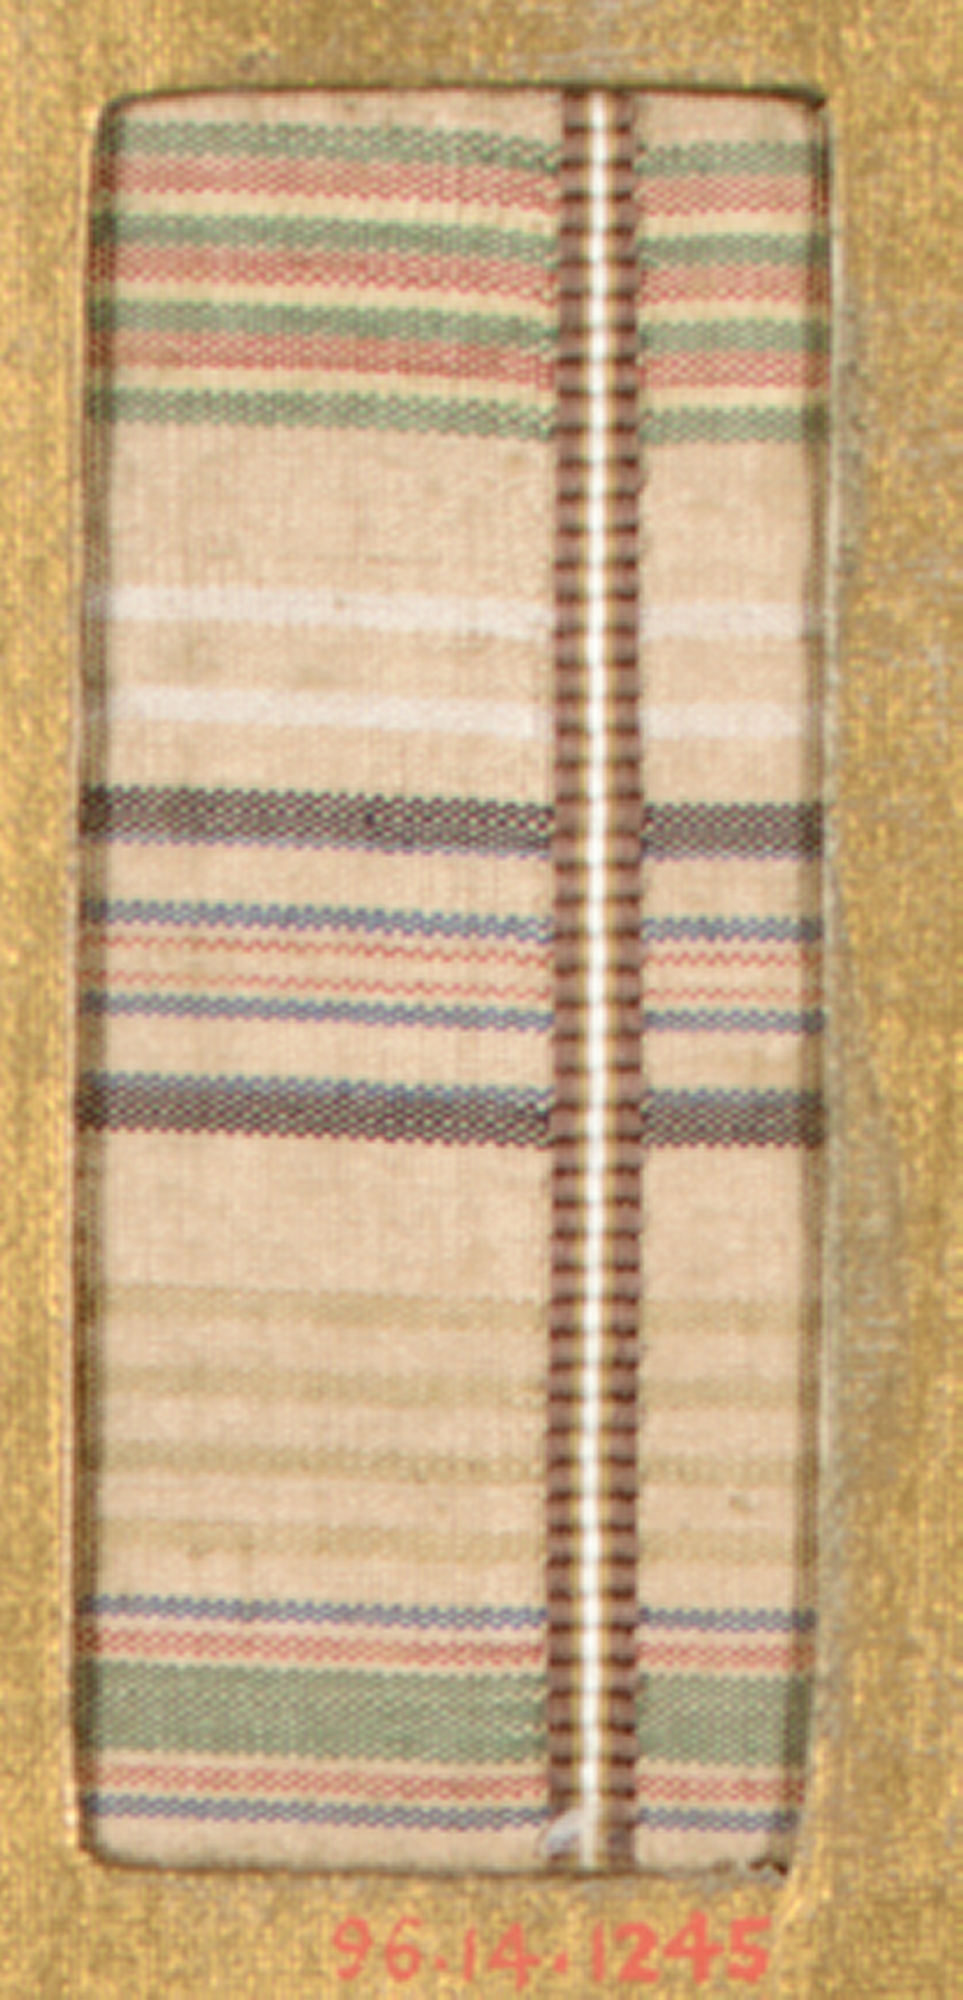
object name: piece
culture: japanese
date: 1701-1900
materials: silk